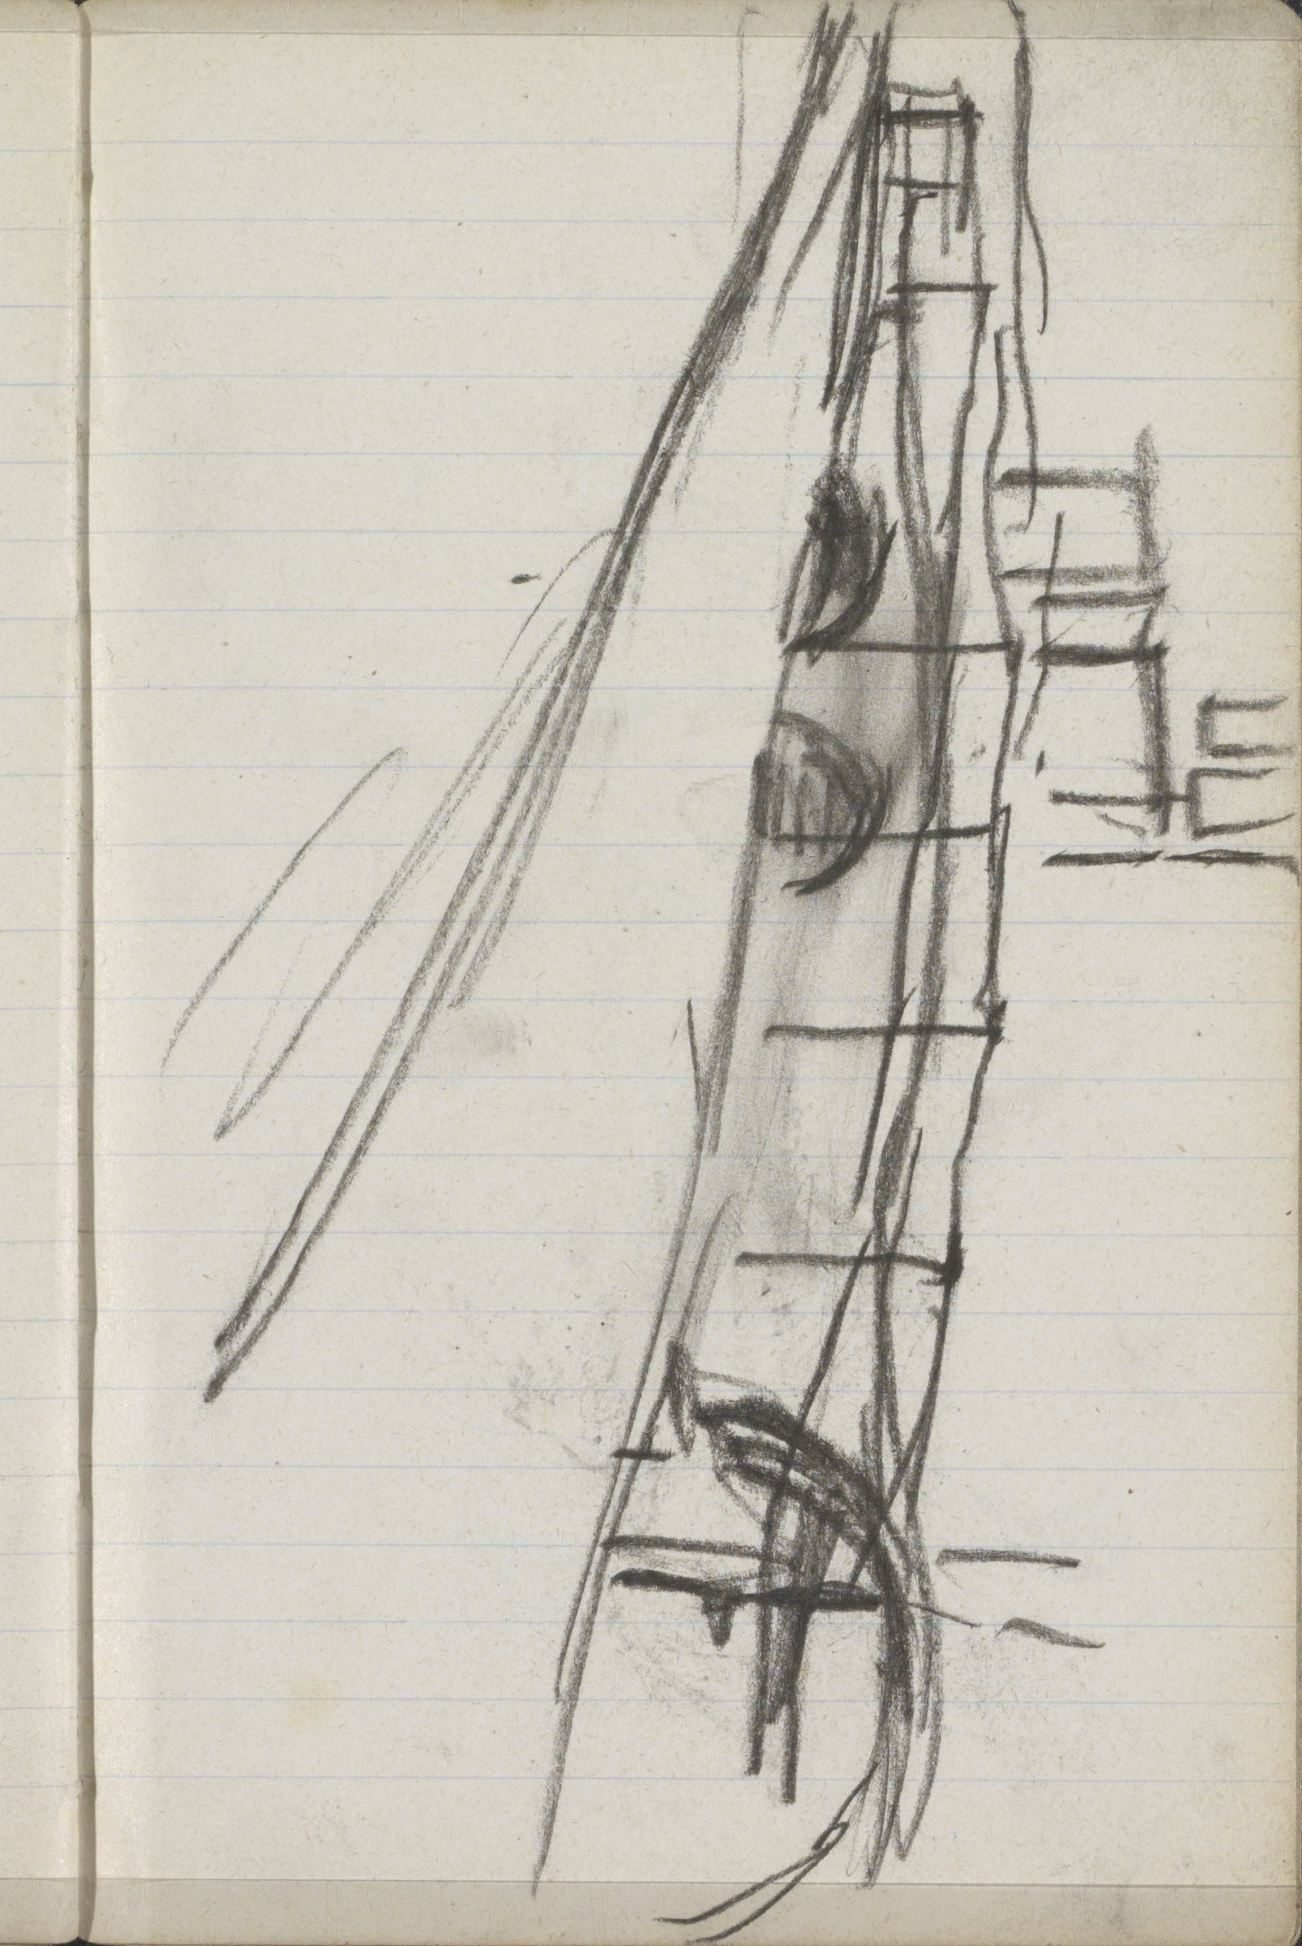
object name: sketchbook leaf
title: Gezicht op een brug over een gracht in Amsterdam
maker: george hendrik breitner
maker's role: draughtsman, painter, print maker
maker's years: 1857-1923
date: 1893-1898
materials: chalk, paper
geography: amsterdam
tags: canals, waters (in city), amsterdam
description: Pagina 56 uit een schetsboek met 31 bladen.